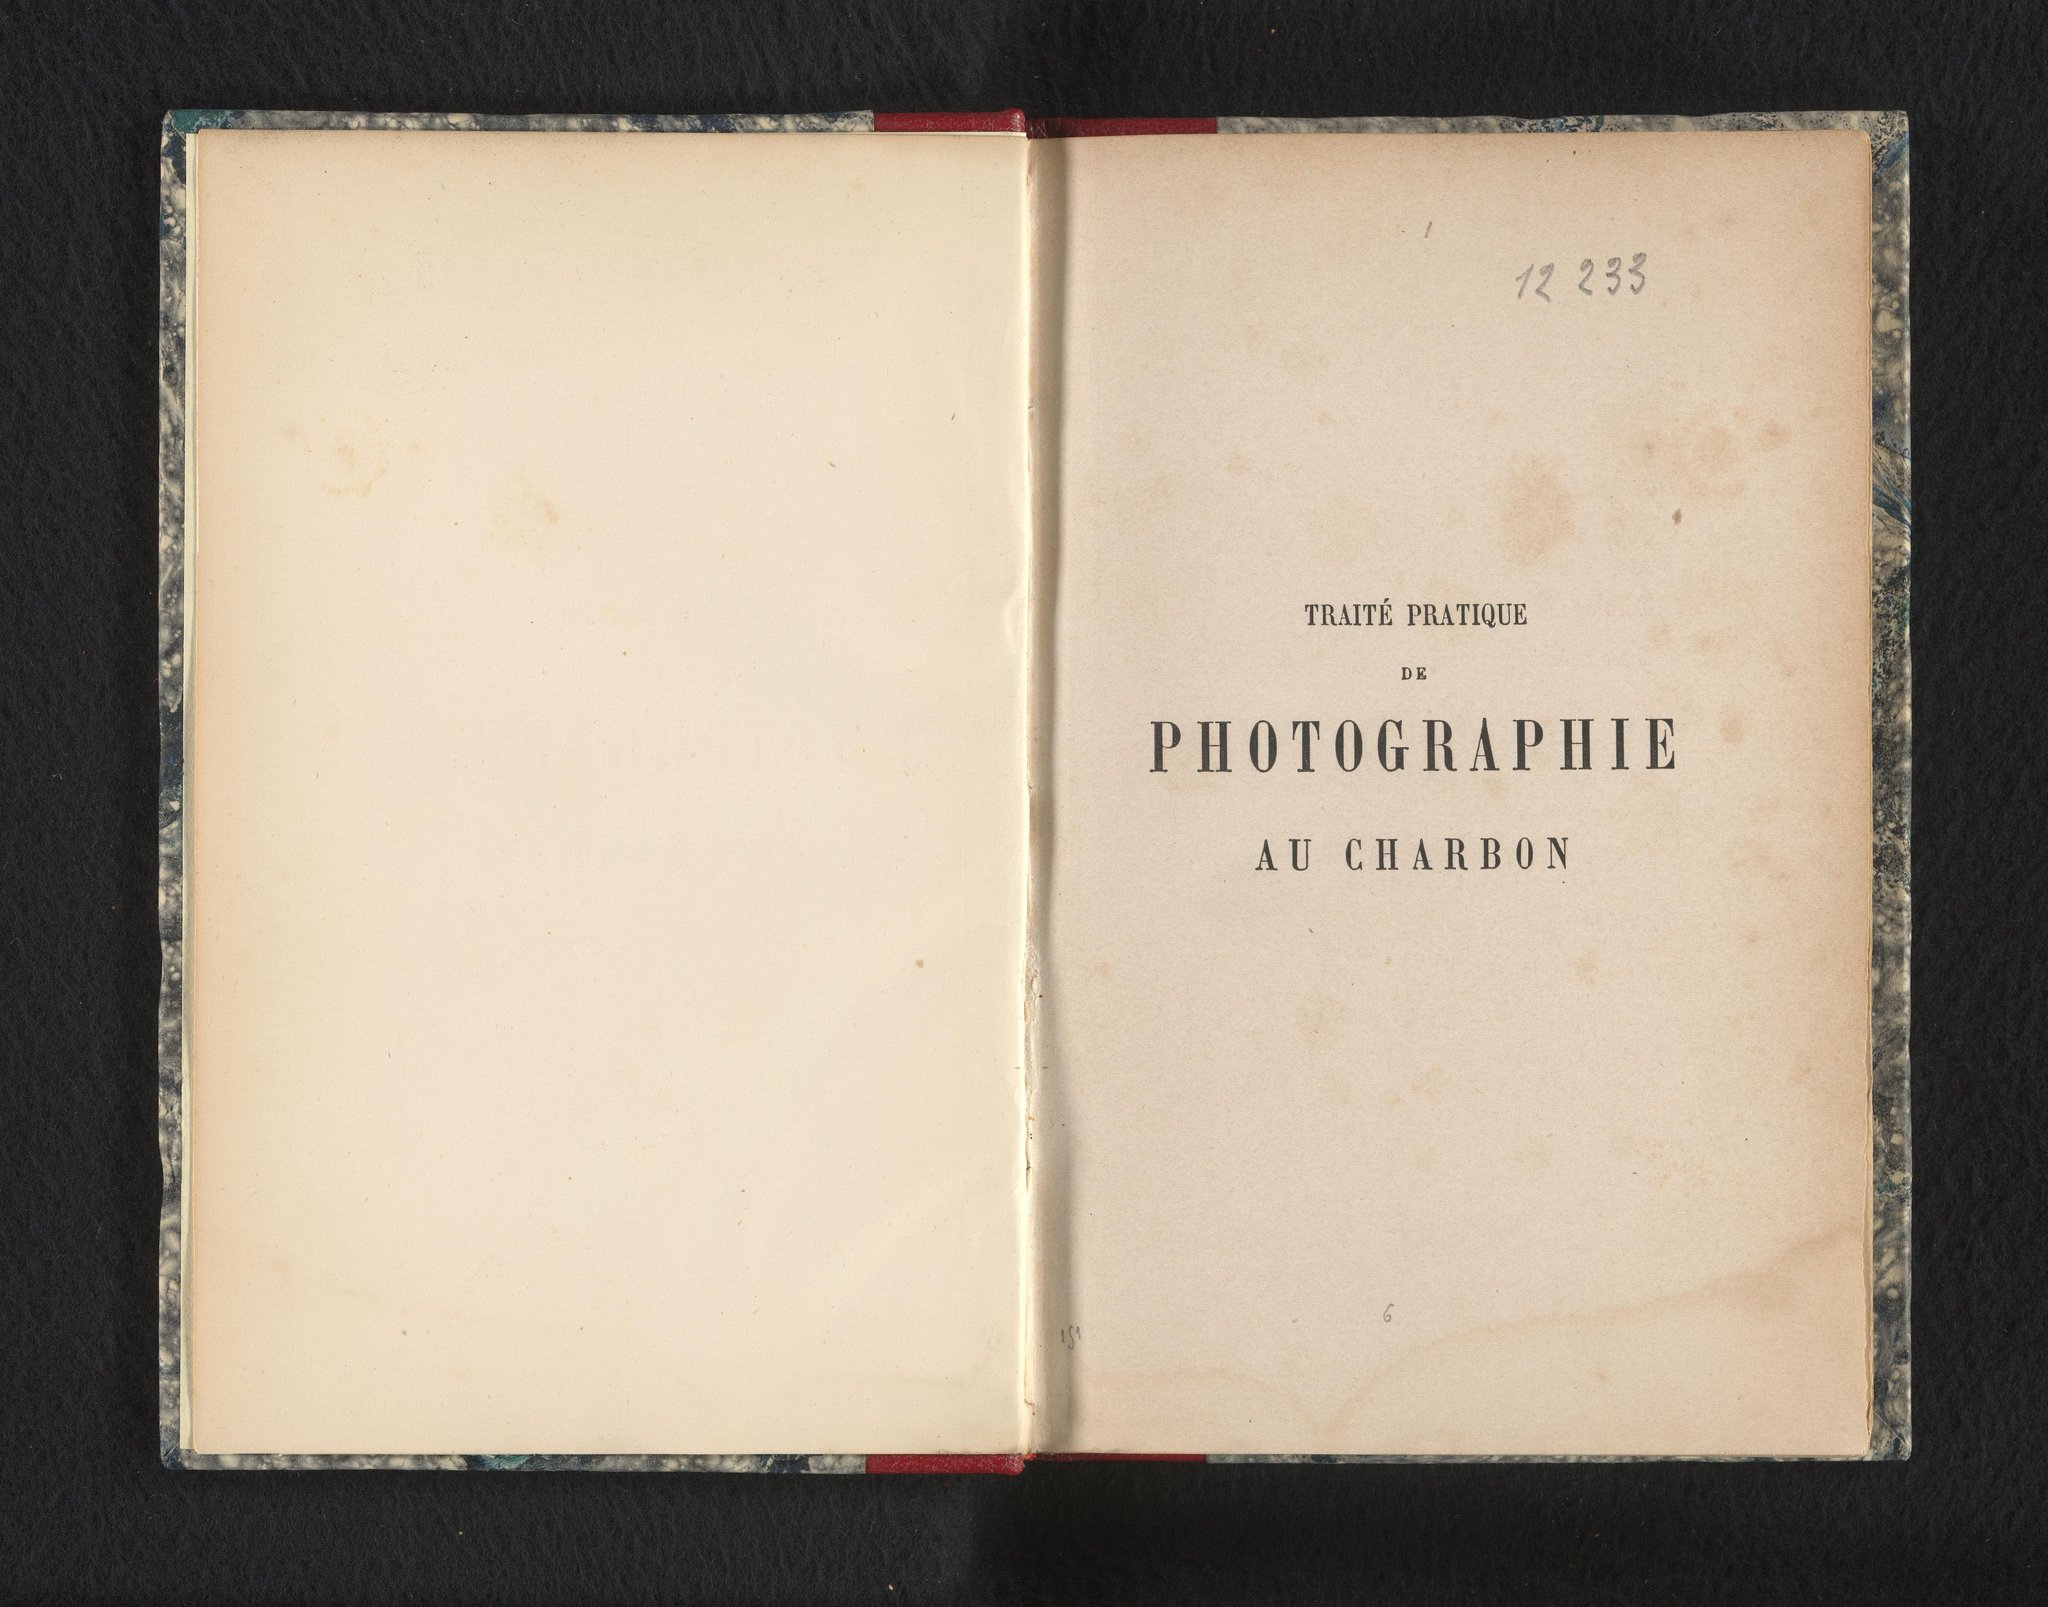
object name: book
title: Traité pratique de photographie au charbon : complété par la description de divers procédés d'impressions inaltérables : photochromie et tirages photomécaniques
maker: léon vidal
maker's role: fotograaf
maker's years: 1833-1906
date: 1877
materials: cardboard, leather, paper, photographic process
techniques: photograph, letterpress printing, lithograph, marbling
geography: paris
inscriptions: inscription: ‘$200-18%’, date: ‘NOV 2021’